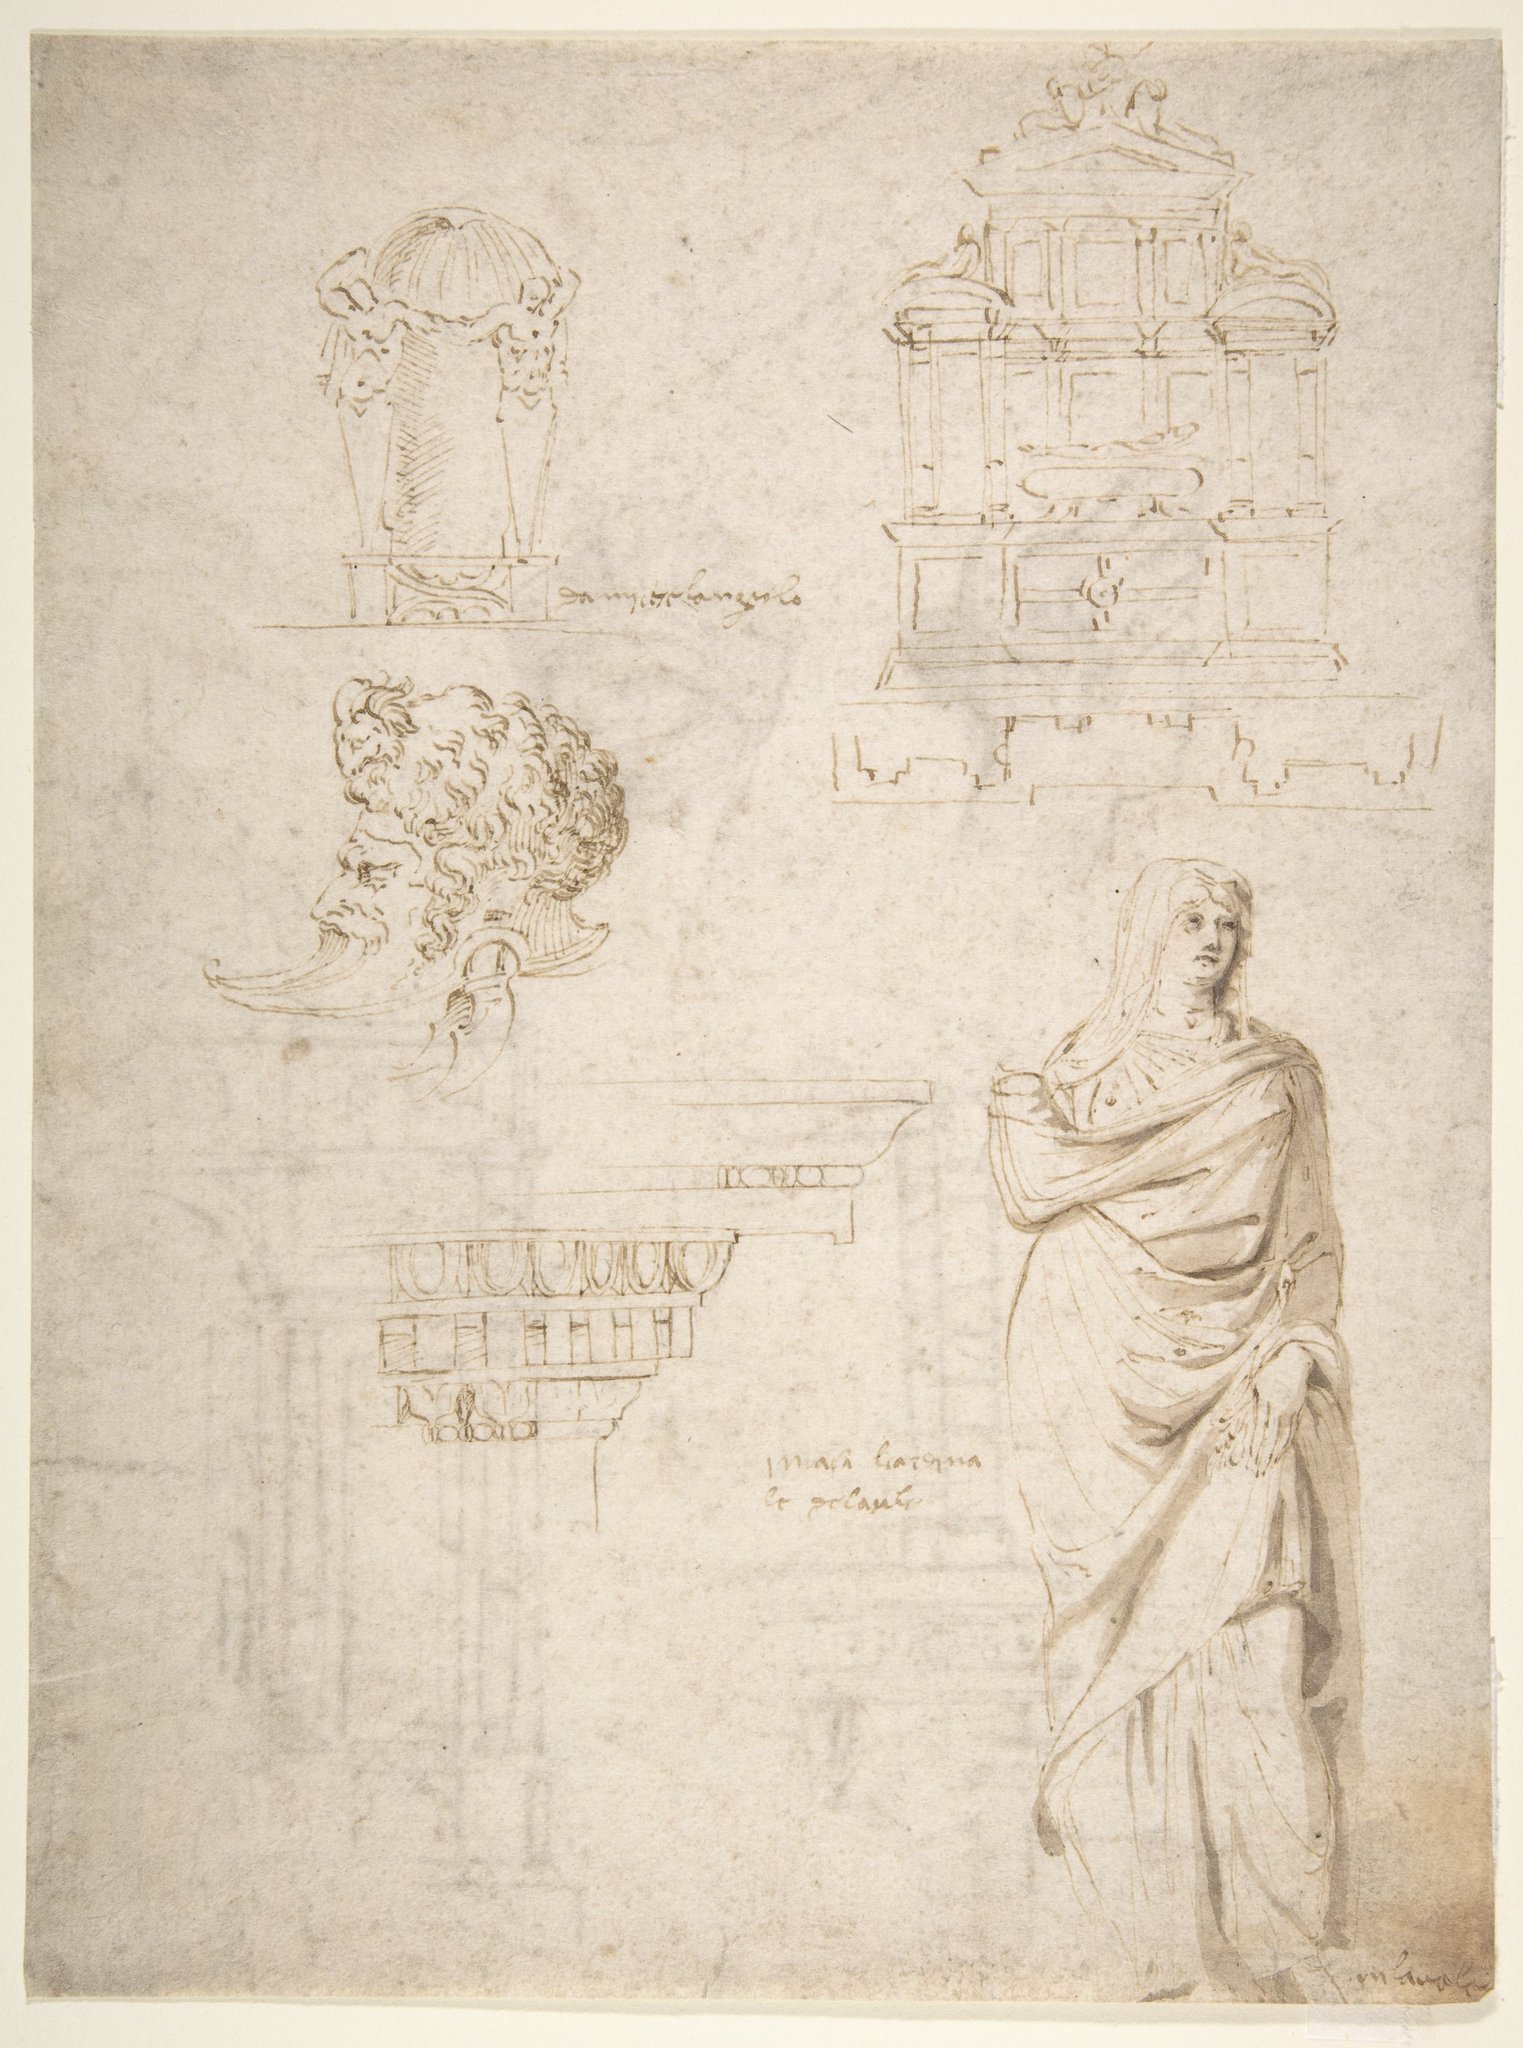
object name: drawing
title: Sketches of a Funeral Monument, a Niche with Statues, a Helmet in the Shape of a Human Head, an Entablature and a Female Statue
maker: michelangelo buonarroti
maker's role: artist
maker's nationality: italian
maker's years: 1475-1564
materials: ink, drawing material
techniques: brush, pen, wash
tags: fountains,helmets,heads,men,women